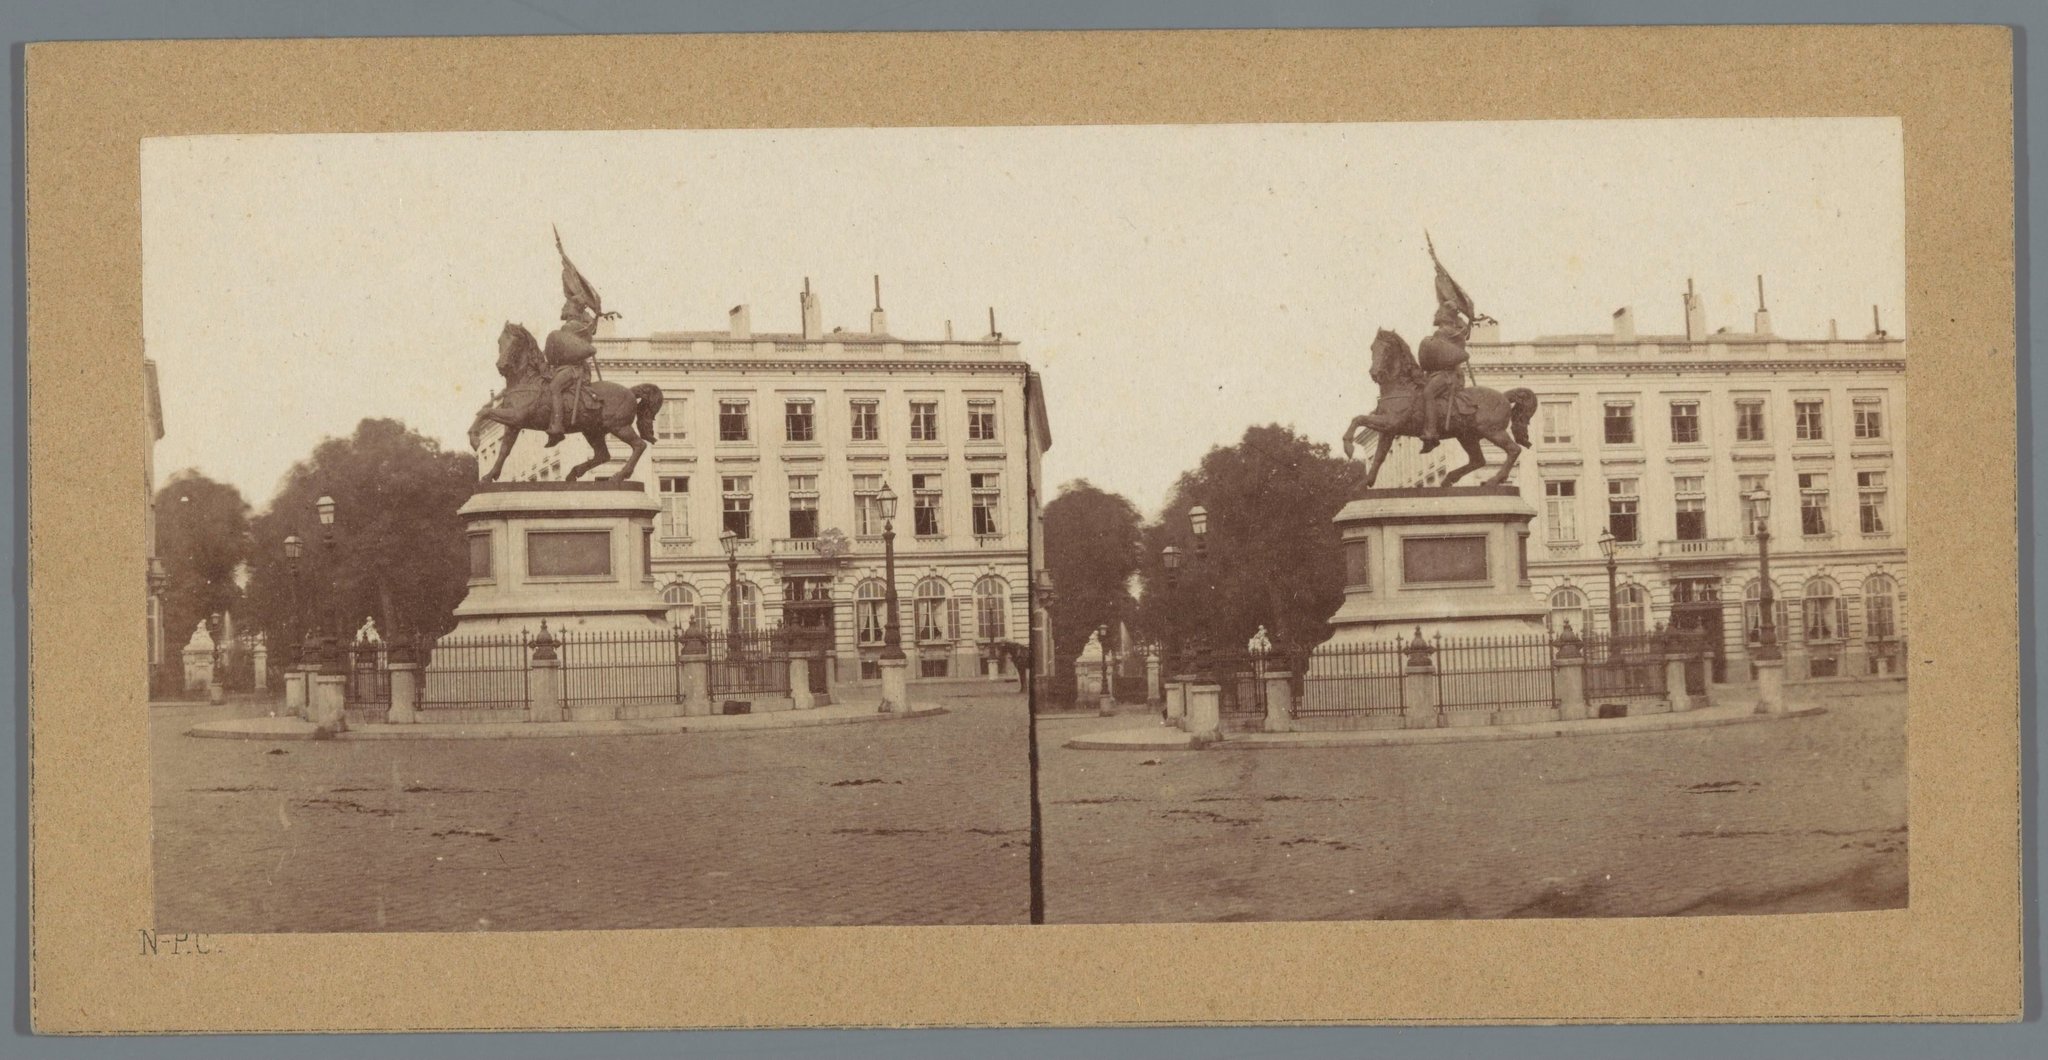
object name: stereograph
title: Gezicht op het standbeeld van Godfried van Bouillon op het Koningsplein in Brussel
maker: n-p.c.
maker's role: fotograaf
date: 1857-1863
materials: cardboard, paper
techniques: albumen print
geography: brussels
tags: godfrey of bouillon, monument, statue